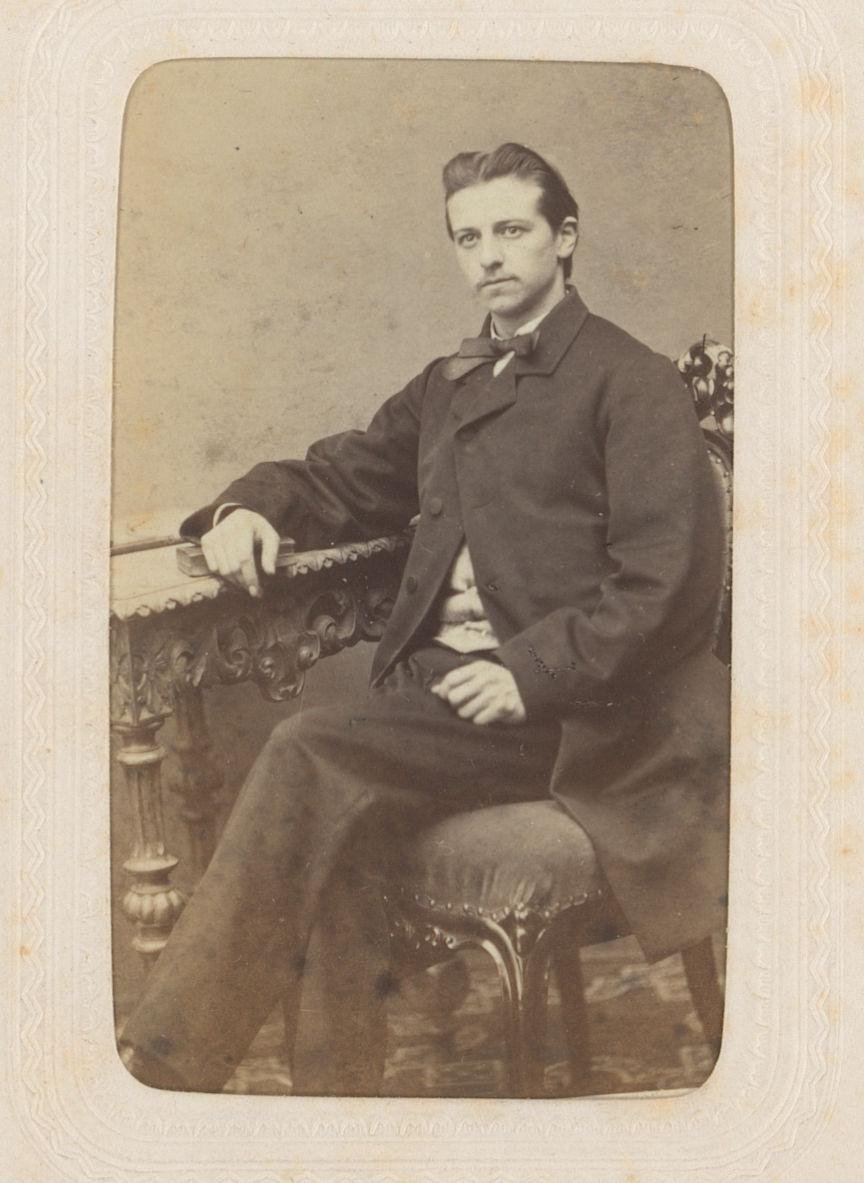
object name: carte de visite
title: Studioportret van een man bij een tafel met ornamenten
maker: albert greiner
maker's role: fotograaf, fotostudio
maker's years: 1833-1890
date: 1863-1866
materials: cardboard, paper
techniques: albumen print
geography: amsterdam